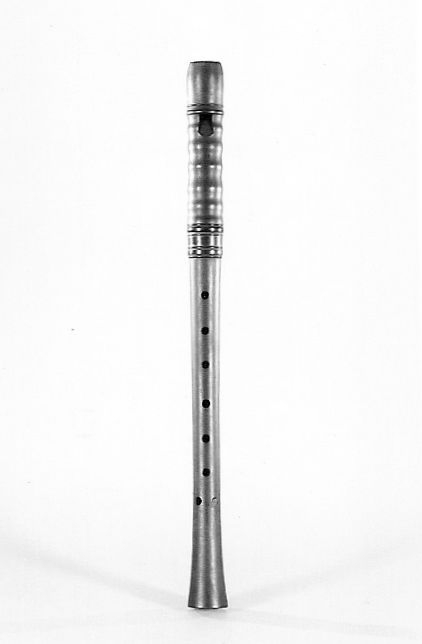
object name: tenor recorder in c sharp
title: Tenor Recorder in C-sharp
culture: german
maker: hieronimus franciscus kynseker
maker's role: maker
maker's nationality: german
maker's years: 1636-1686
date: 1801-1900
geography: germany